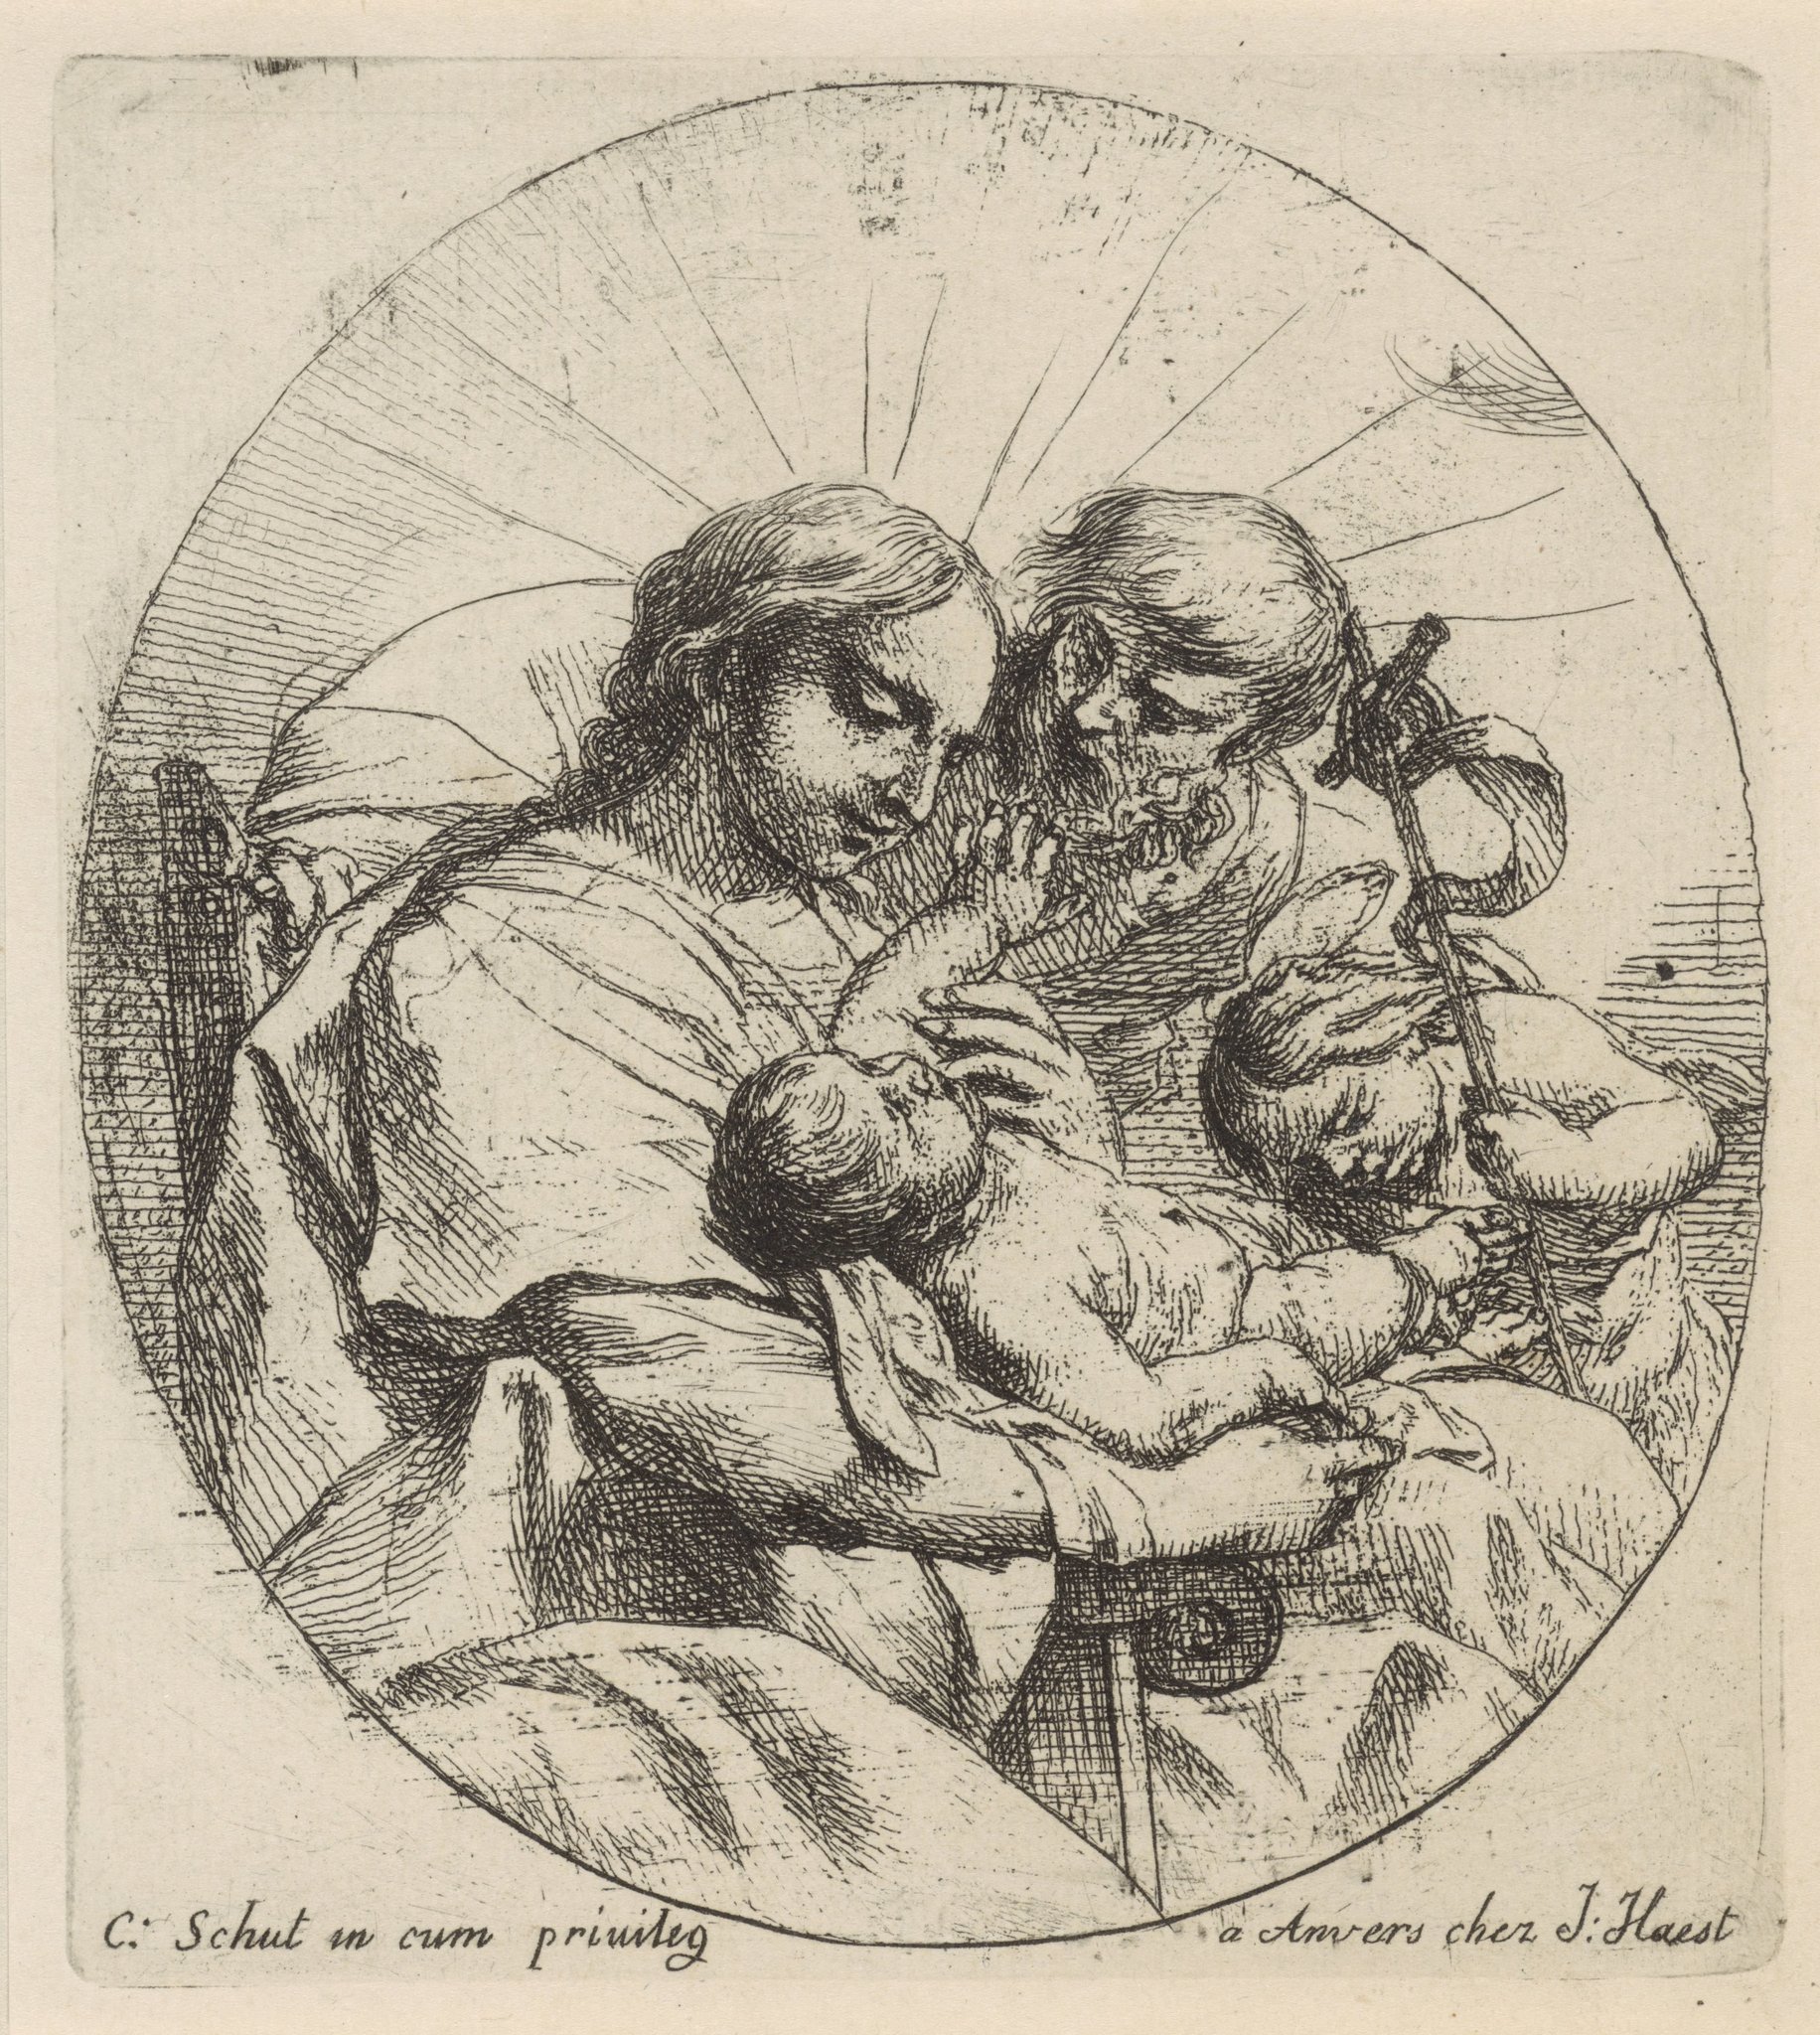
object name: print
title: Heilige Familie met Johannes de Doper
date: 1618-1655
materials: paper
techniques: etching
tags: holy family with john the baptist (as child)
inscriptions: collector's mark: Lugt 2228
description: Maria zit op een stoel met het Christuskind op schoot. Het kind reikt naar de baard van Jozef, die zich naar Maria wendt. De jonge Johannes de Doper buigt zich over de voeten van het kind. In zijn hand heeft hij een overwinningsbanier.